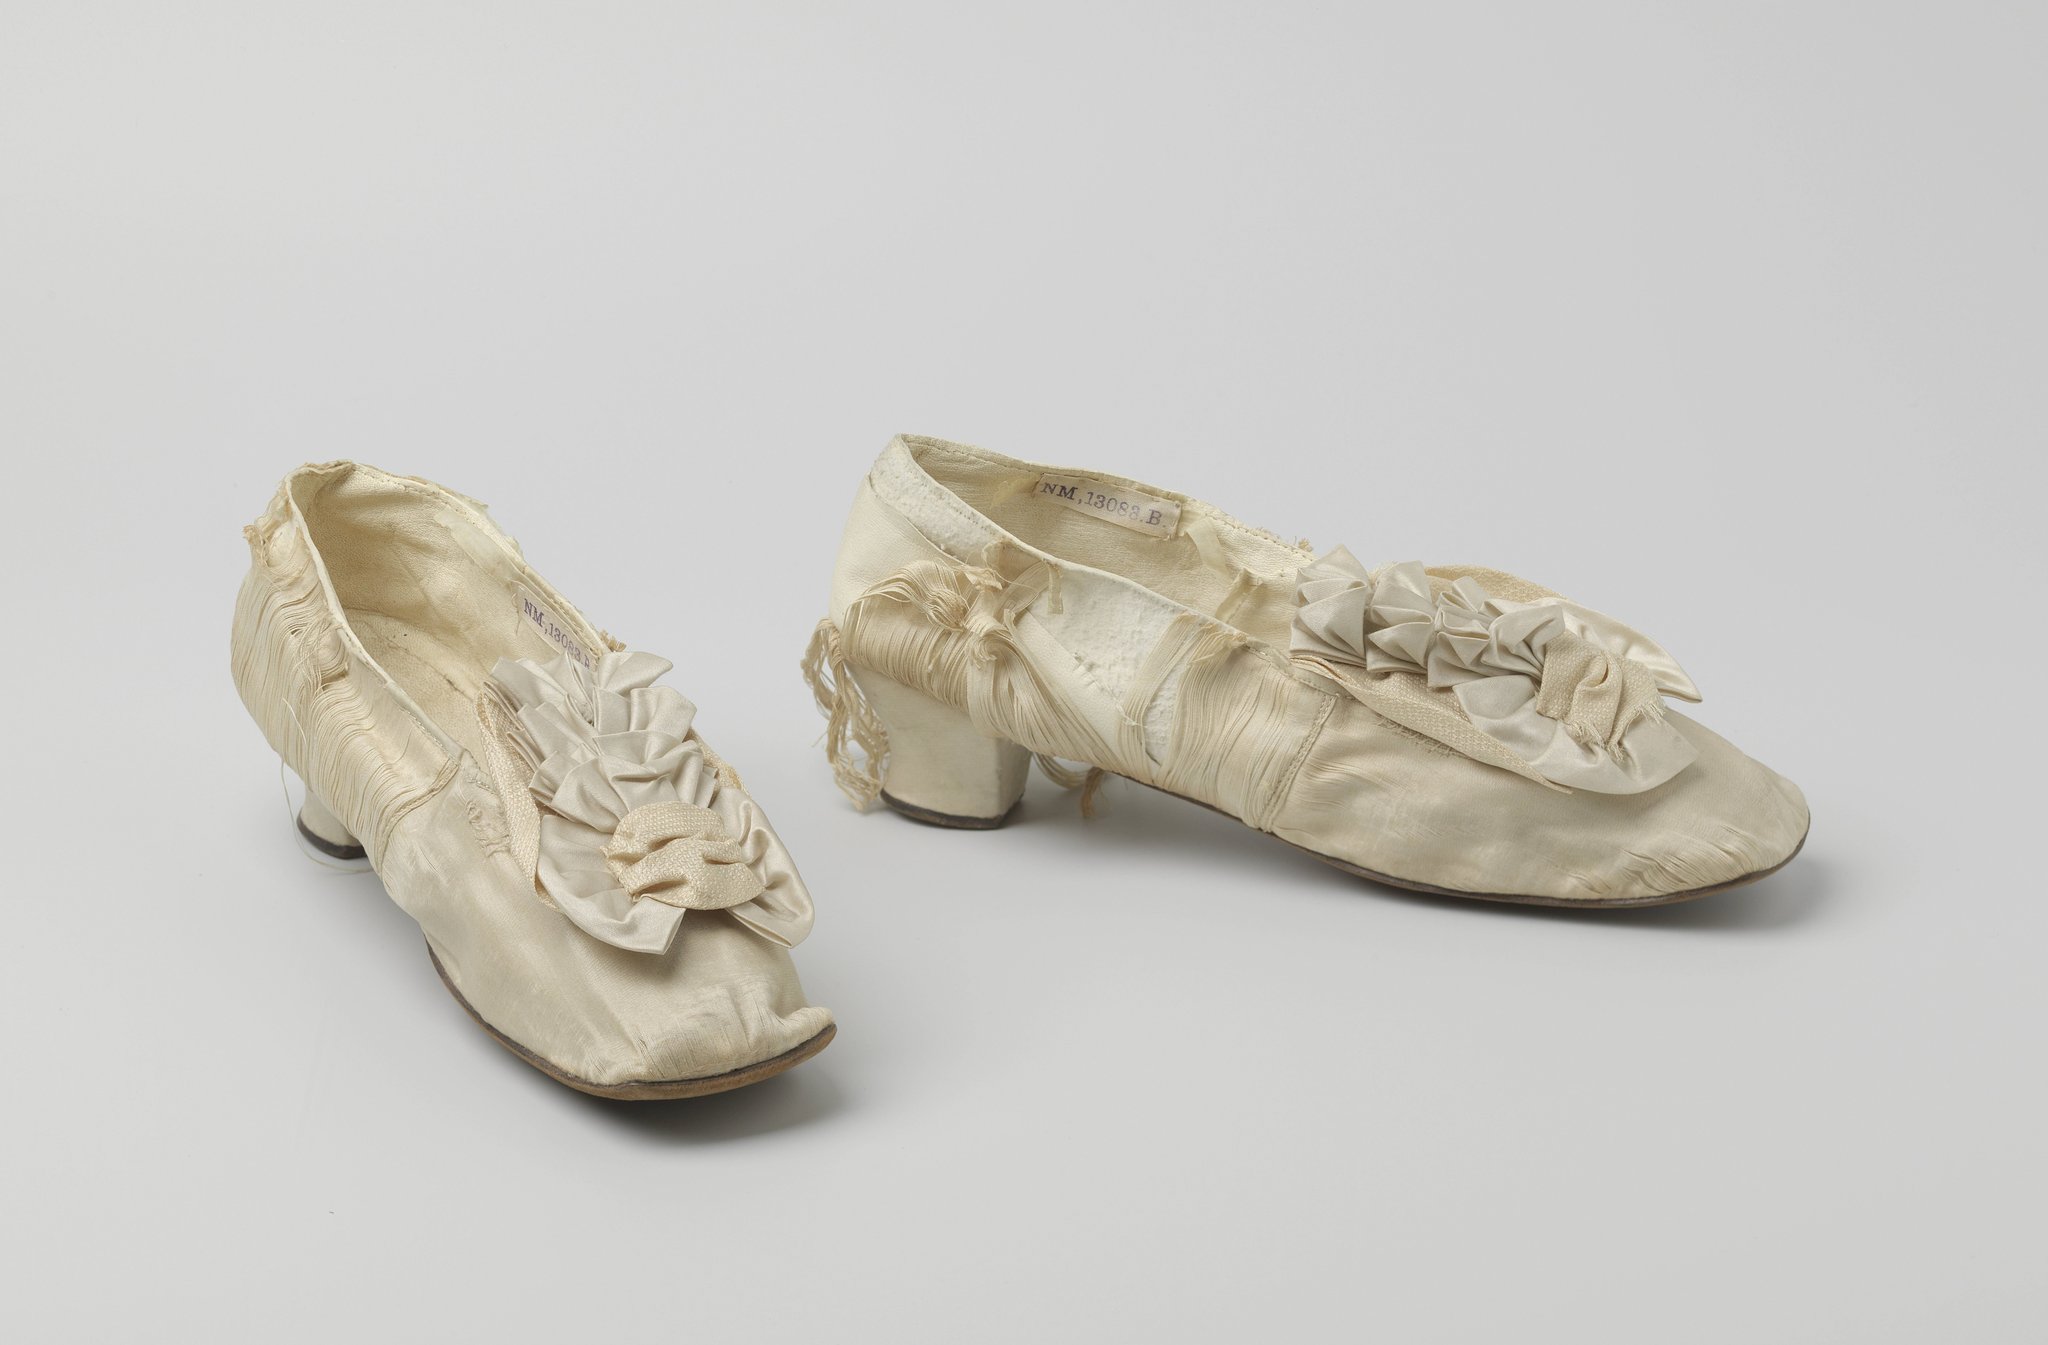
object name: womenswear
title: Balschoen van wit satijn met strikken op de voorschoen, vierkante neus en driekwart hak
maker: Anonymous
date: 1850-1860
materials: leather, textile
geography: netherlands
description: Balschoen van wit satijn met strikken op de voorschoen, vierkante neus en driekwart hak.